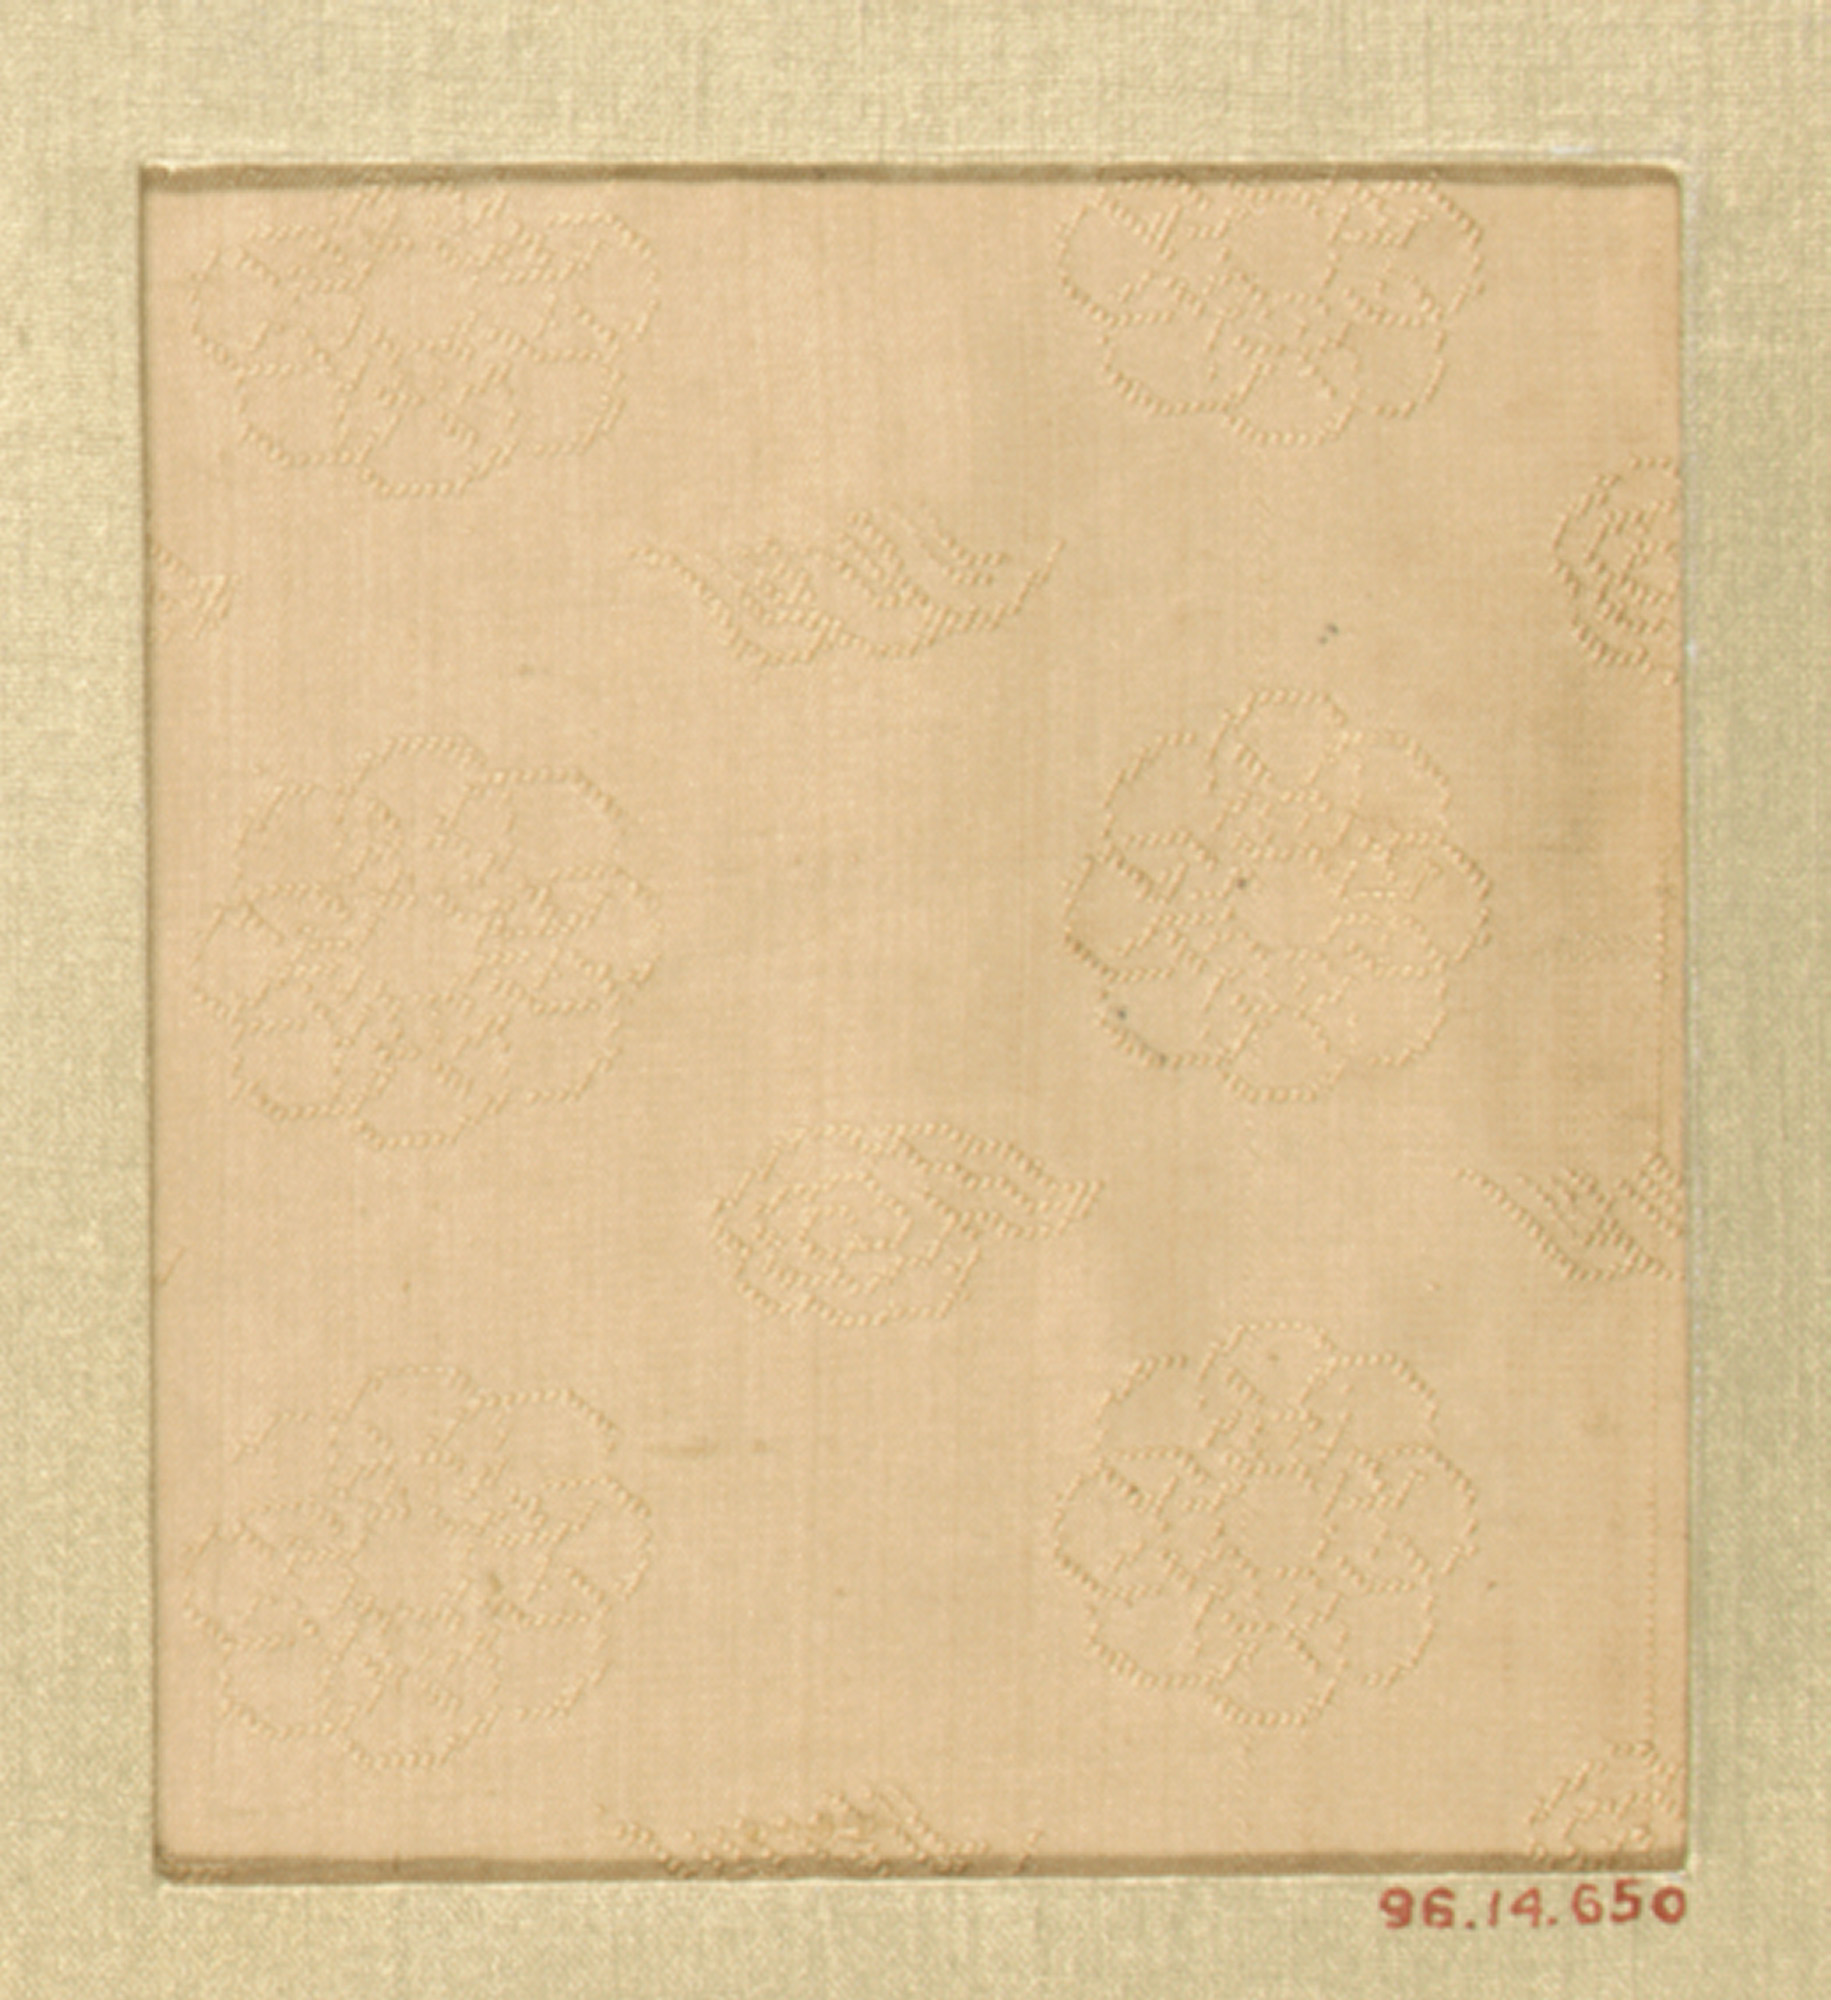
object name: piece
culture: japanese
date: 1701-1900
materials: silk